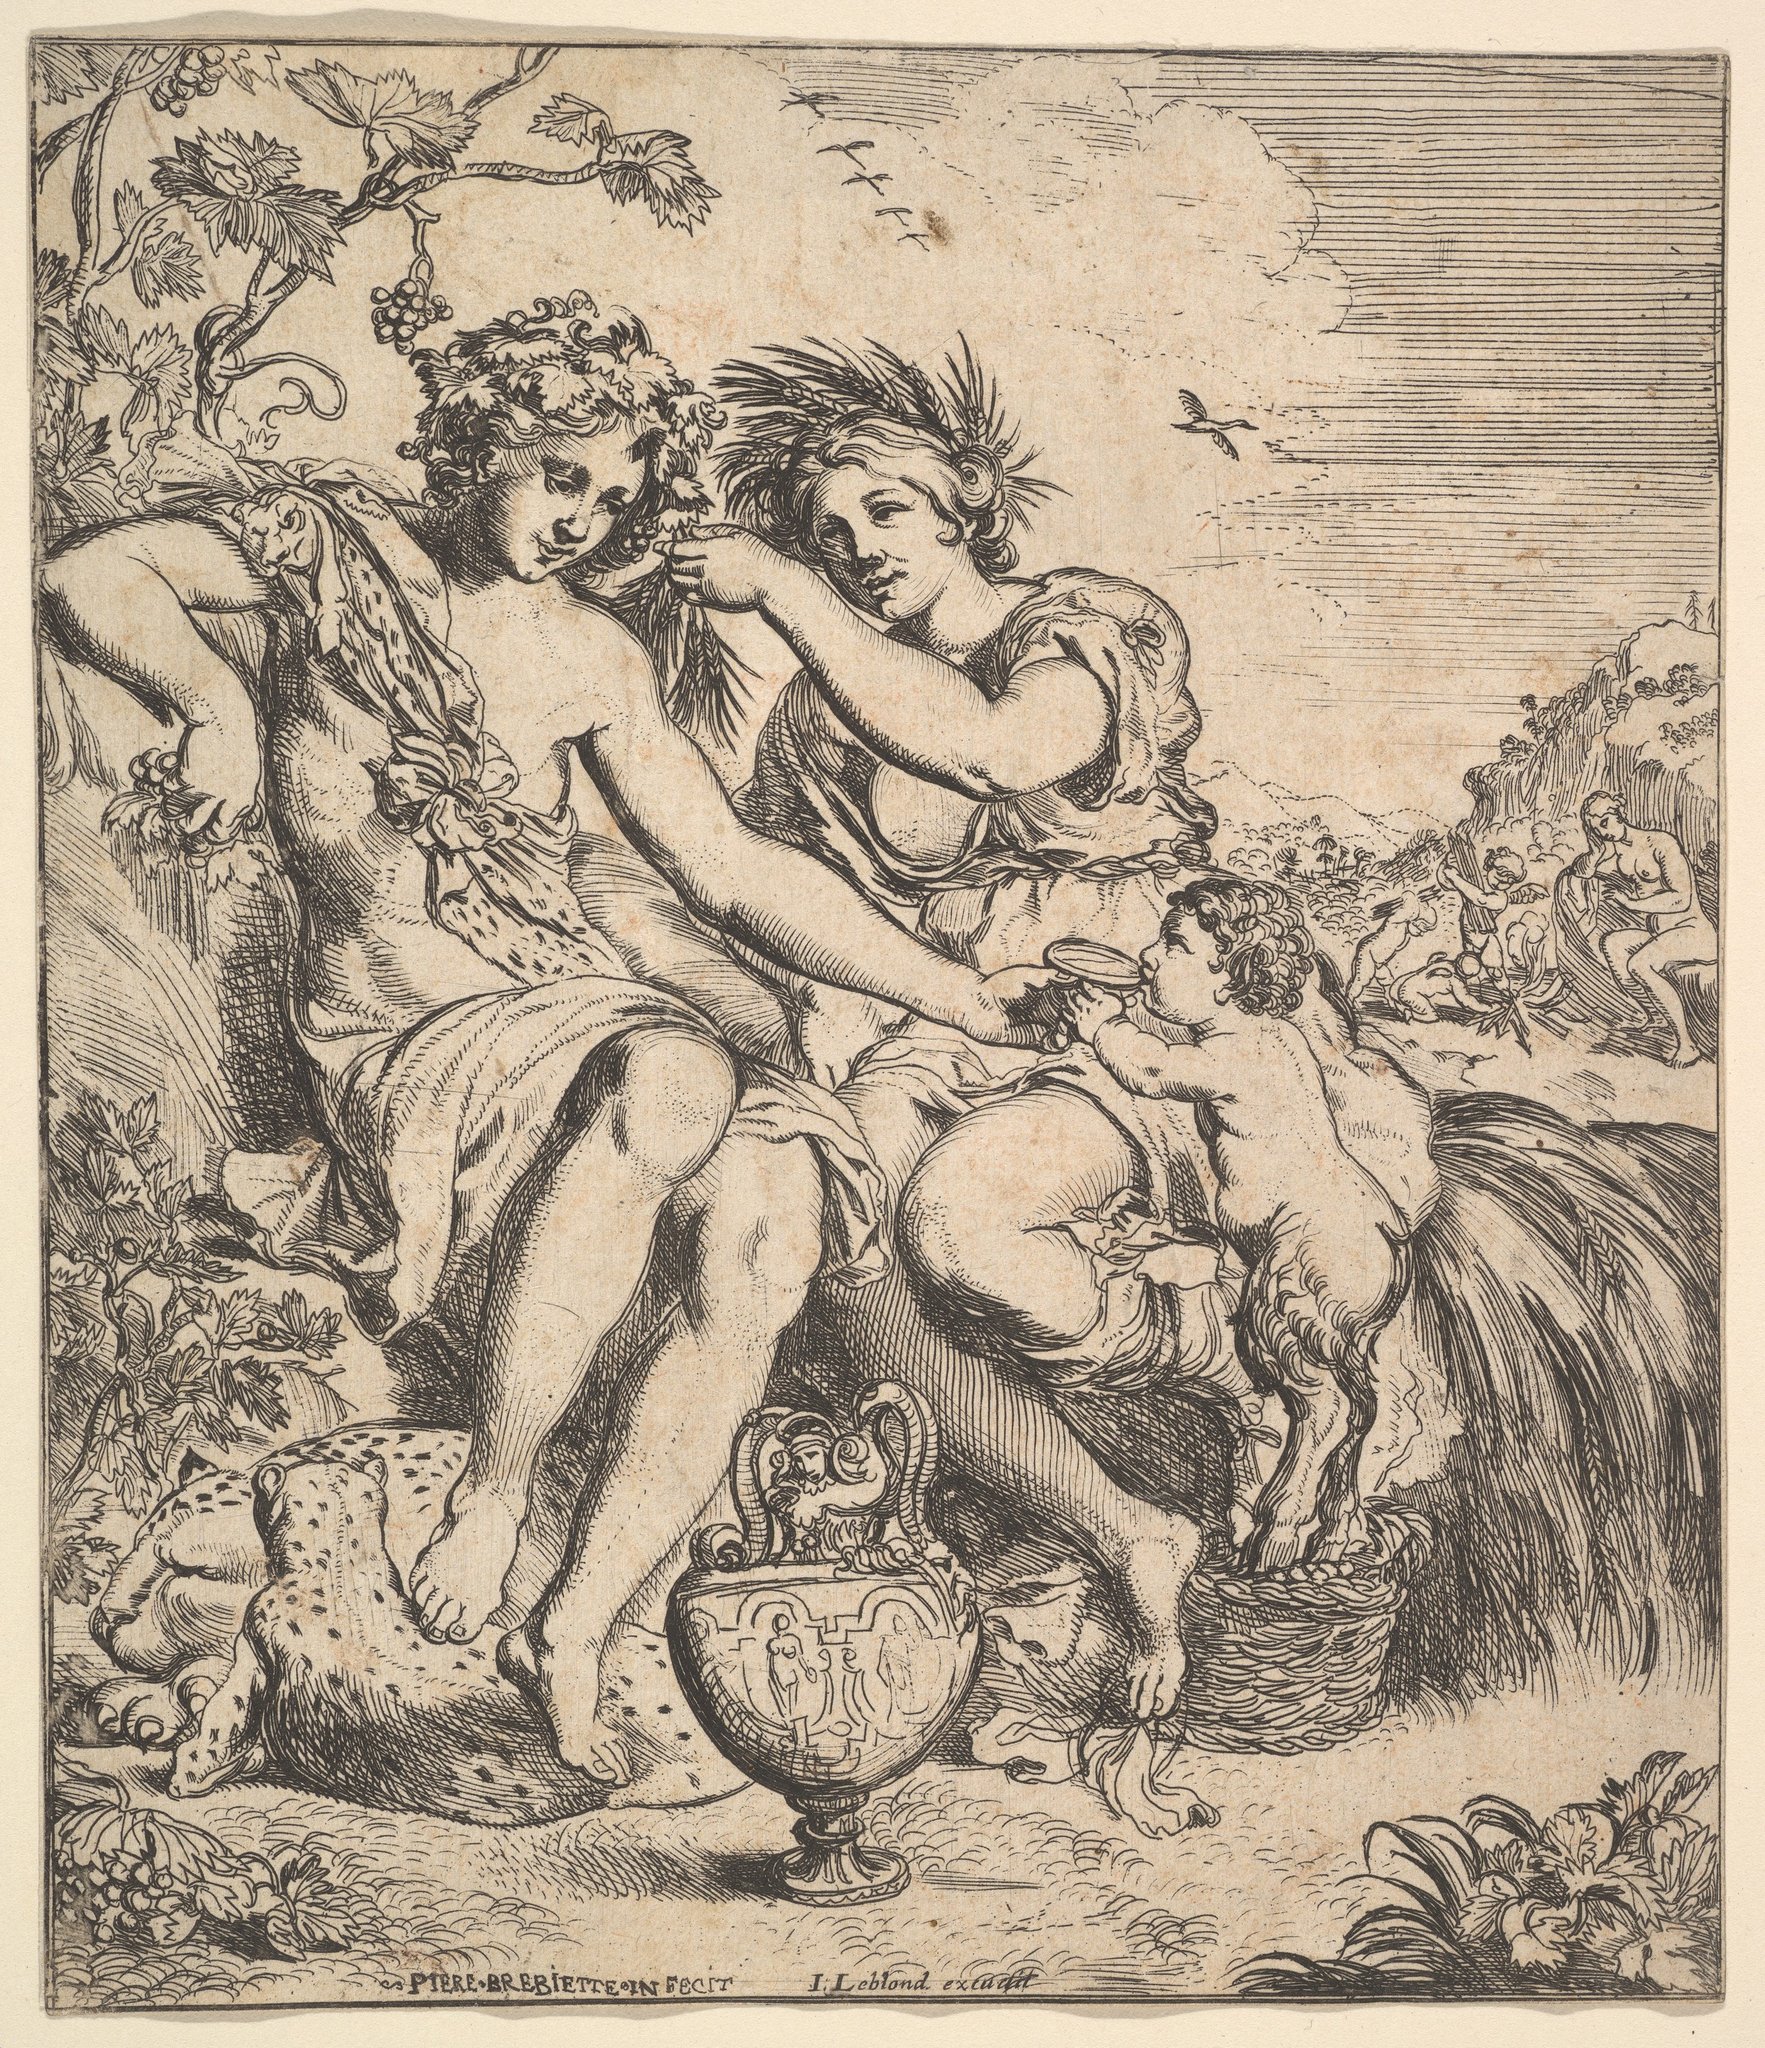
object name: print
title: The Alliance of Bacchus and Ceres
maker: pierre brebiette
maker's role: artist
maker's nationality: french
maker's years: 1598-1642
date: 1610-1642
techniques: etching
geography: france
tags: animals,bacchus,ceres